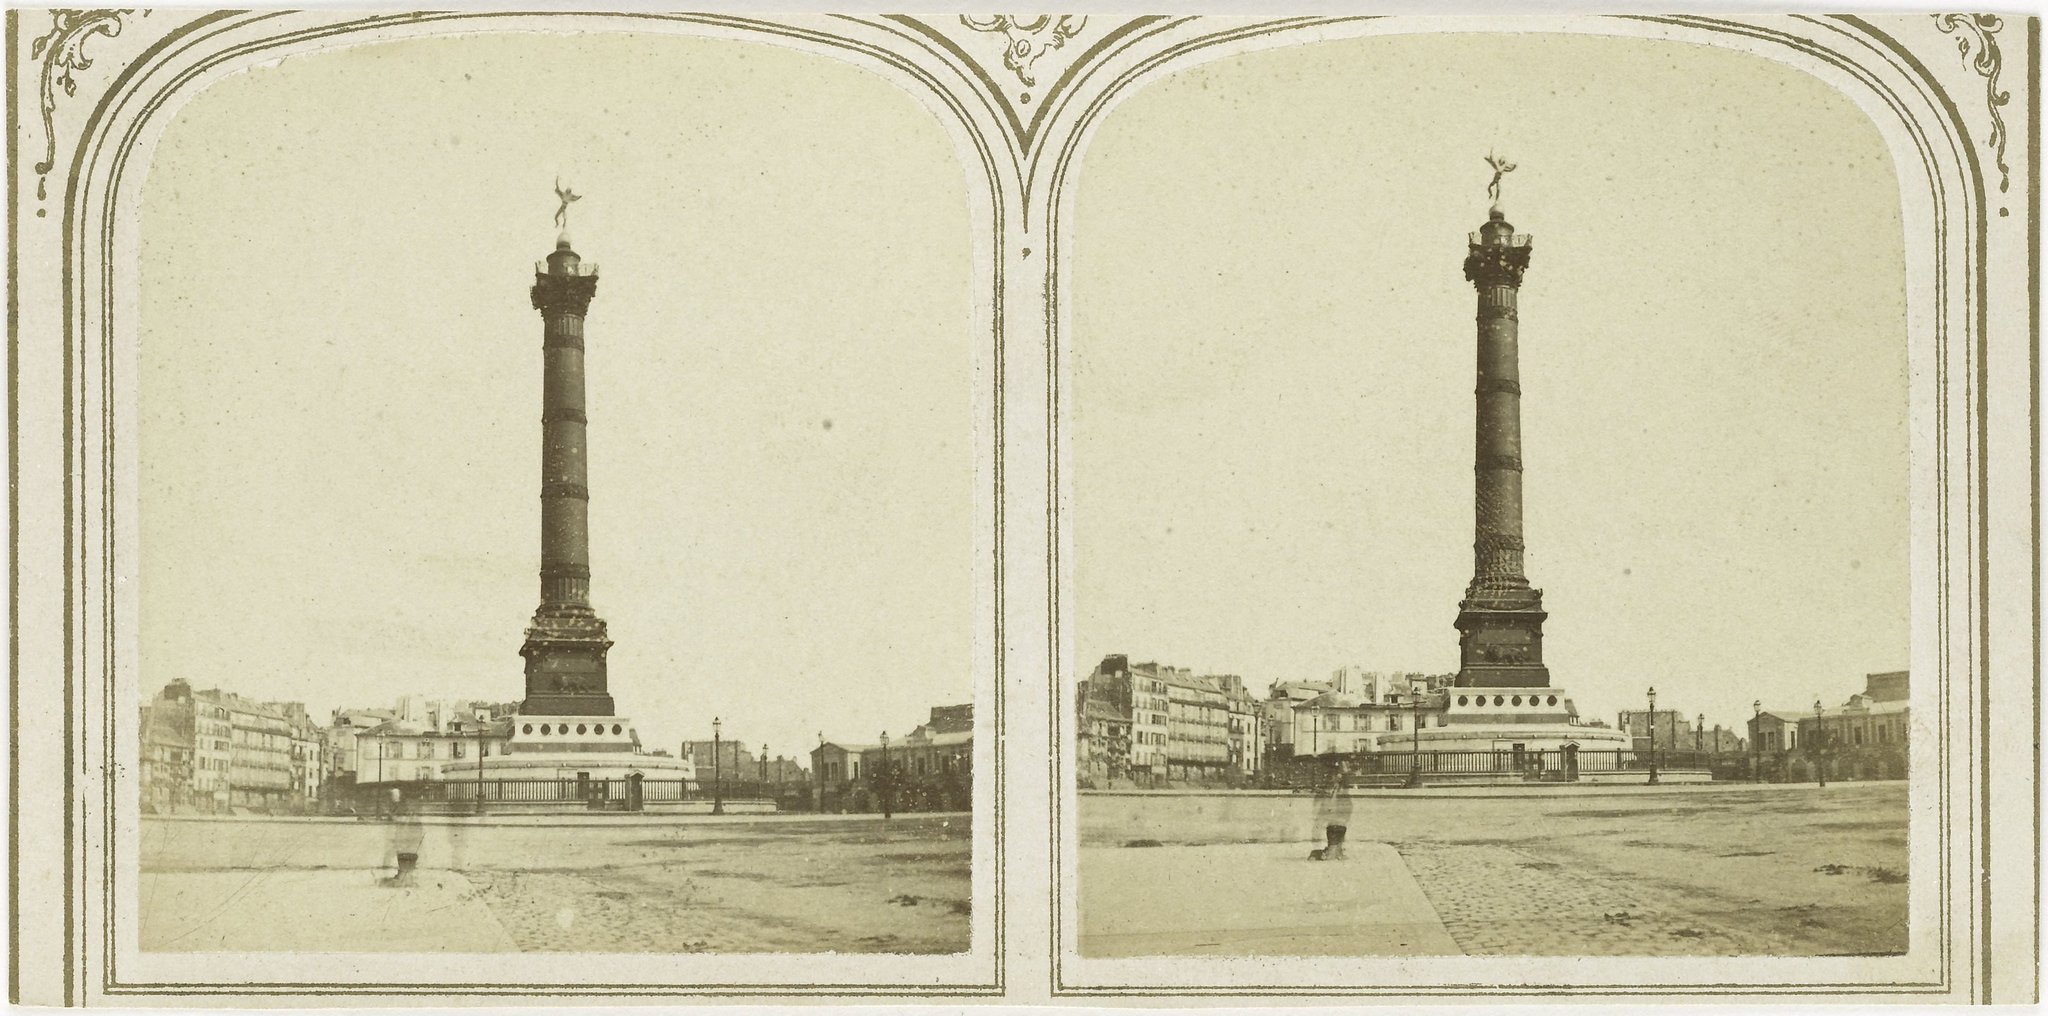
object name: stereograph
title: Gezicht op Place de la Bastille in Parijs met de Colonne de Juillet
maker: Anonymous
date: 1855-1860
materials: cardboard, photographic support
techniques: albumen print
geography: paris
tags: square, place, circus, etc., monument, statue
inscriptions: inscription: ‘Bastille Paris’